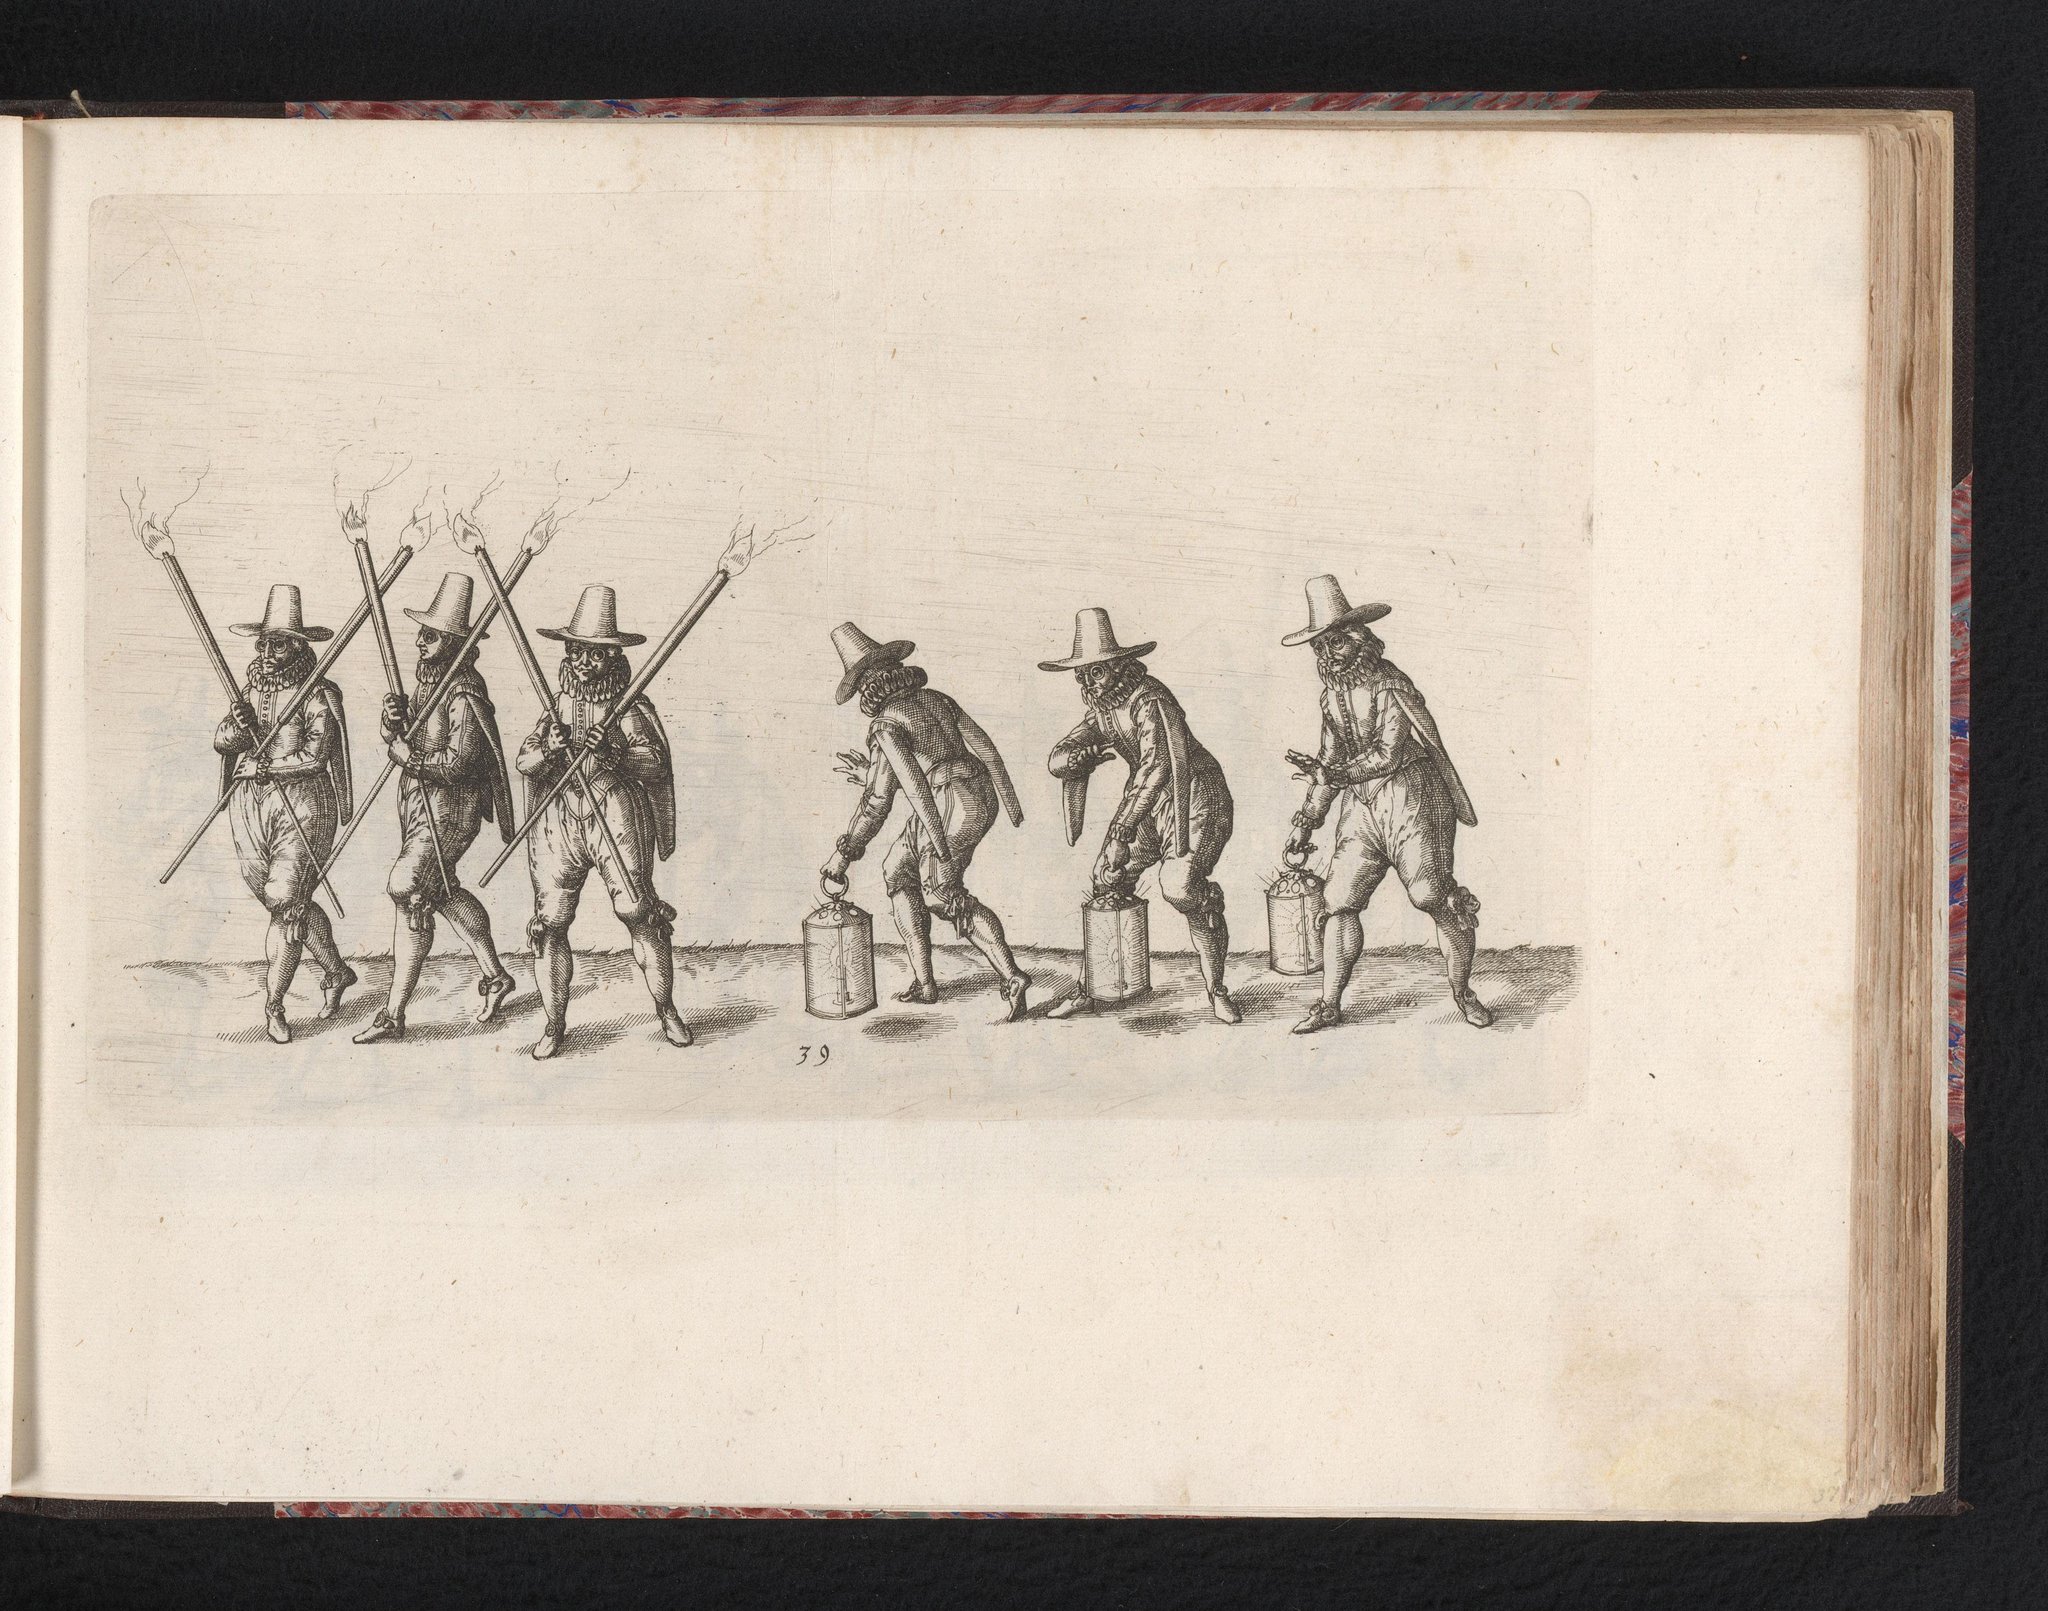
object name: album leaf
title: Optochten en ruiterspelen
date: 1617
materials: paper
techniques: etching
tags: philipp leiningen-westerburg-rixingen (ii), fabulous beings with wings - aa - female human figure, 'laub- und bandelwerk' ~ ornament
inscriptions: date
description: Genummerd: 38. Tekst in het Duits in de cartouche. Deze prent maakt deel uit van een album.